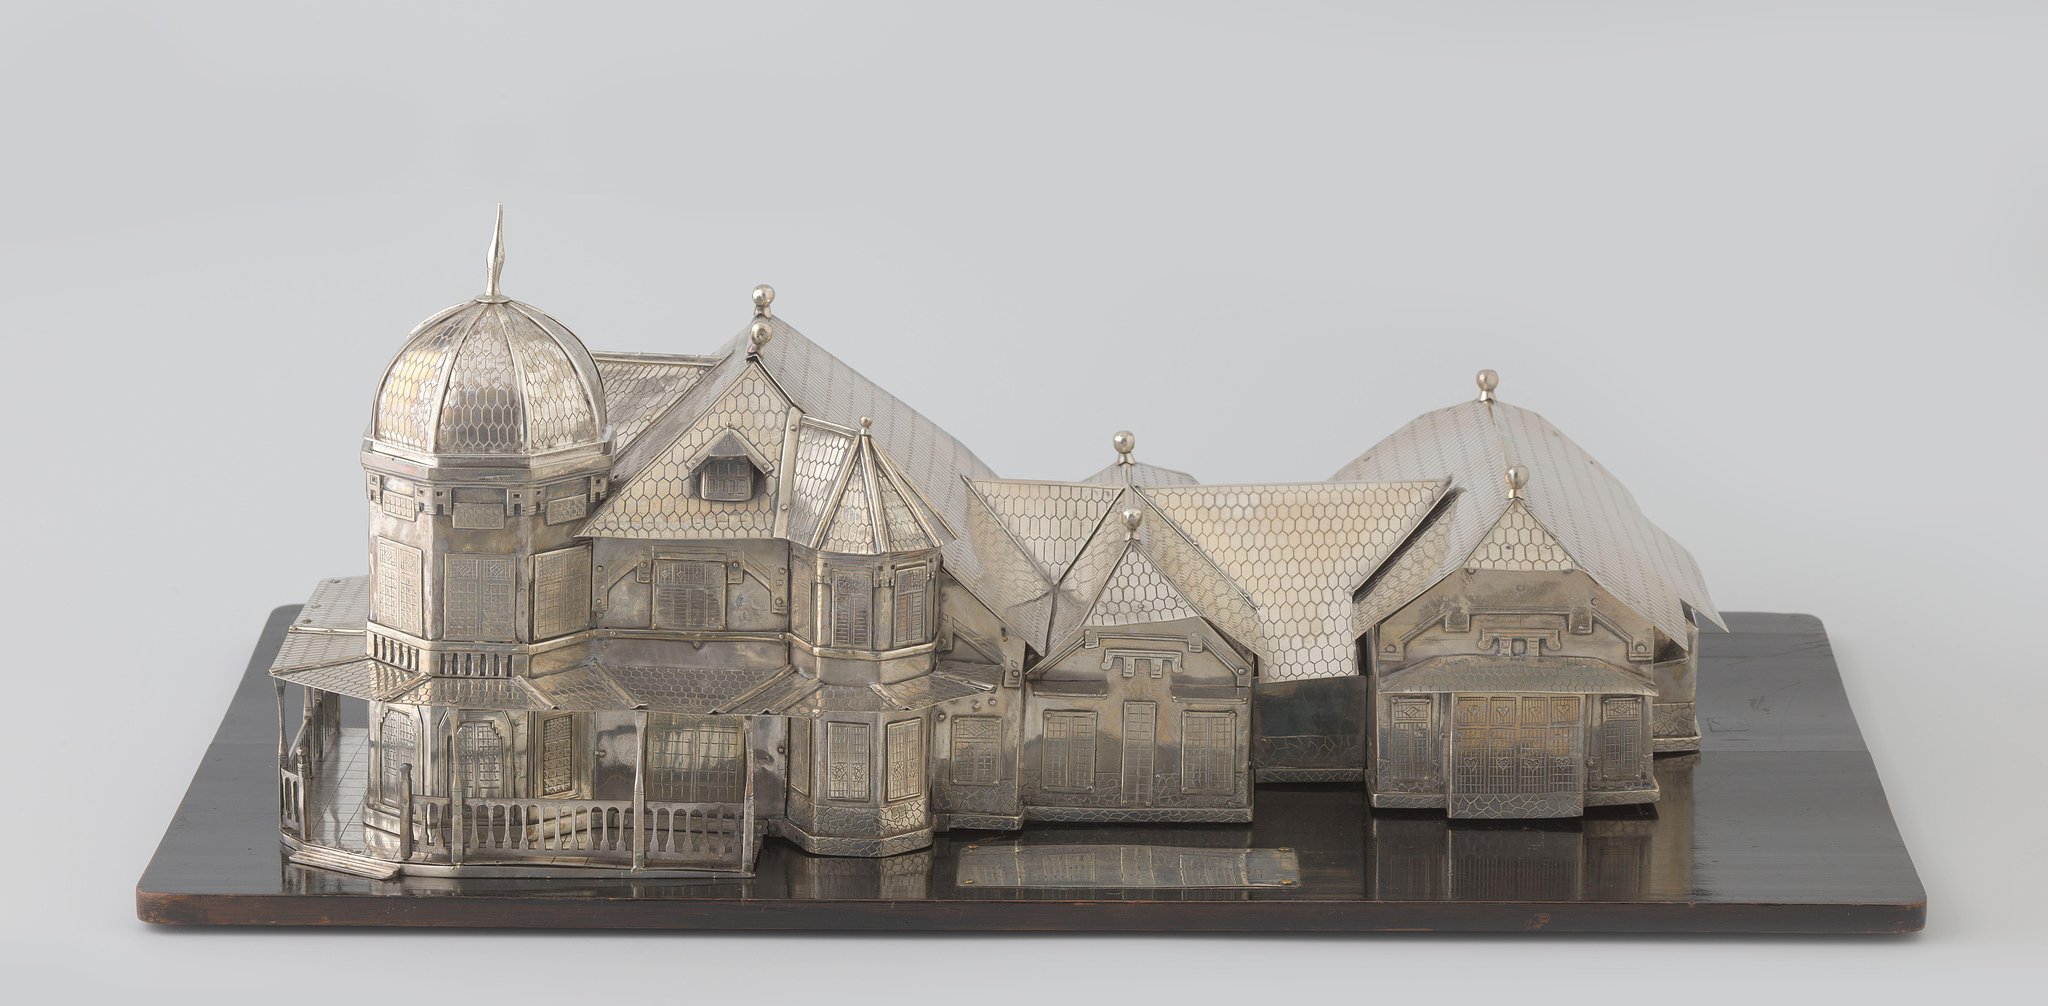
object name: model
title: Een zilveren maquette van een Indonesisch huis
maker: Anonymous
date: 1930-1931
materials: silver, wood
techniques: engraving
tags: civic architecture; edifices; dwellings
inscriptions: inscription: ‘J.J.S. Brandsma, J.A. Kattenbusch, J.L. van Laer, G.J. Lukeij, W.M. O'Hara, C.D. Punt, C.J. Quist, D.J.M.G. Brn van Slingelandt, Jhr L.W. van Suchtelen, A. ter Kuhle, Dr P.W. Toussieng, A.J.W. Vorster, Mr H.H.A. van West, E.C.A. Winckel, Mr G.A. Yssel de Schepper, G.J. Zuyderhoff’, label: ‘Hulde aan Marinus Wins op zijn 50sten geboortedag, Malang - 18 Juni 1931’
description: Een zilveren maquette van een Indonesisch huis. Huis gemaakt op los houten plateau met zilver etiket met opdracht. De daken zijn afneembaar, aan de binnenzijde een gegraveerde lijst van de huldebrengers.